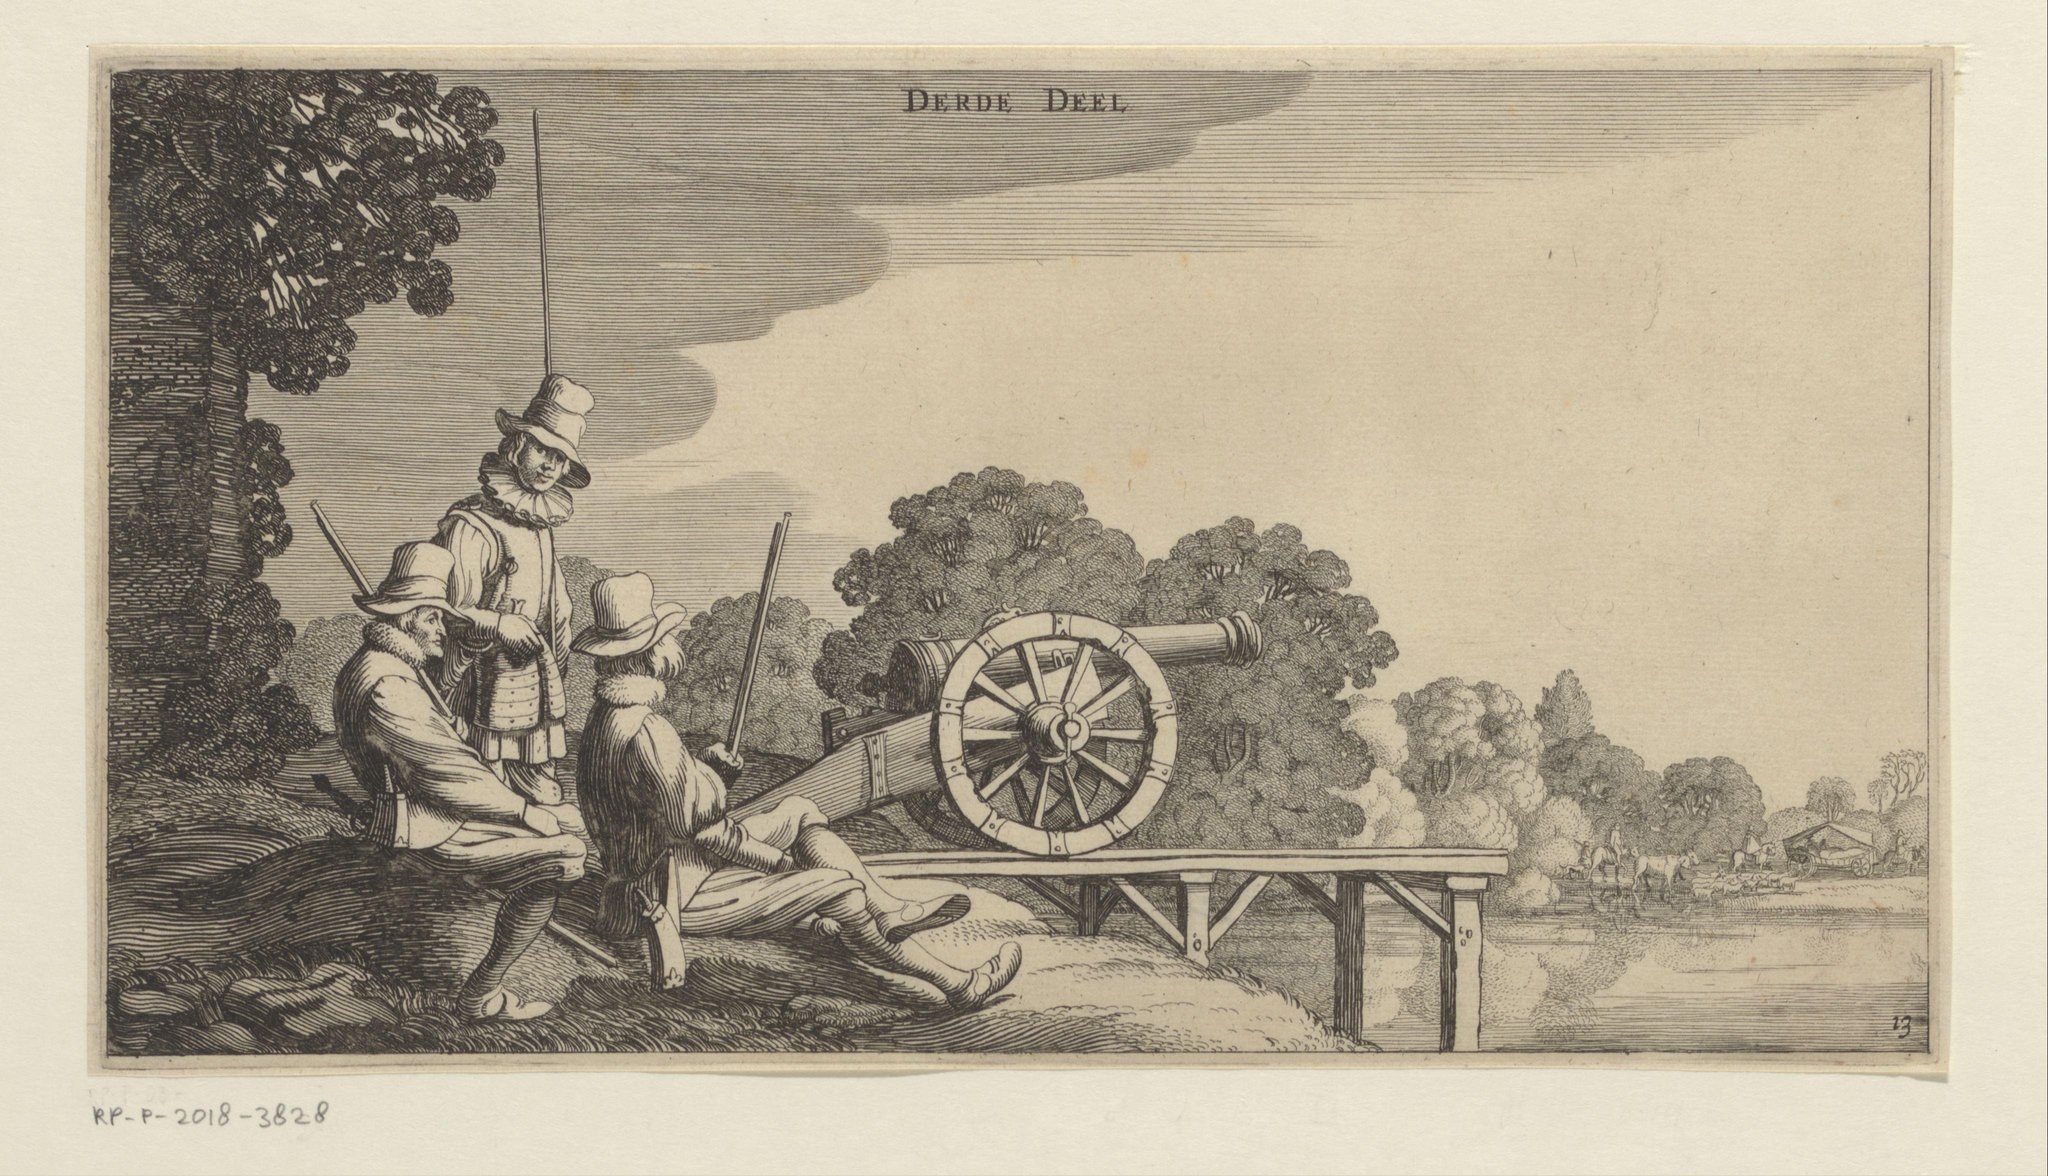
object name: print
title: Playsante lantschappen ende vermakelycke gesichten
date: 1639-1641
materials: paper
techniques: etching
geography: northern netherlands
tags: firearms: cannon, the soldier; the soldier's life, pier, quay, wharf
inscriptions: collector's mark: Lugt 698, collector's mark: Lugt 240, collector's mark: Lugt 2228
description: Dit betreft de dertiende prent van een serie met 36 prenten van landschappen, verdeeld over zes delen. De serie werd na de dood van Jan van de Velde (II) uitgegeven door Claes Jansz. Visscher.